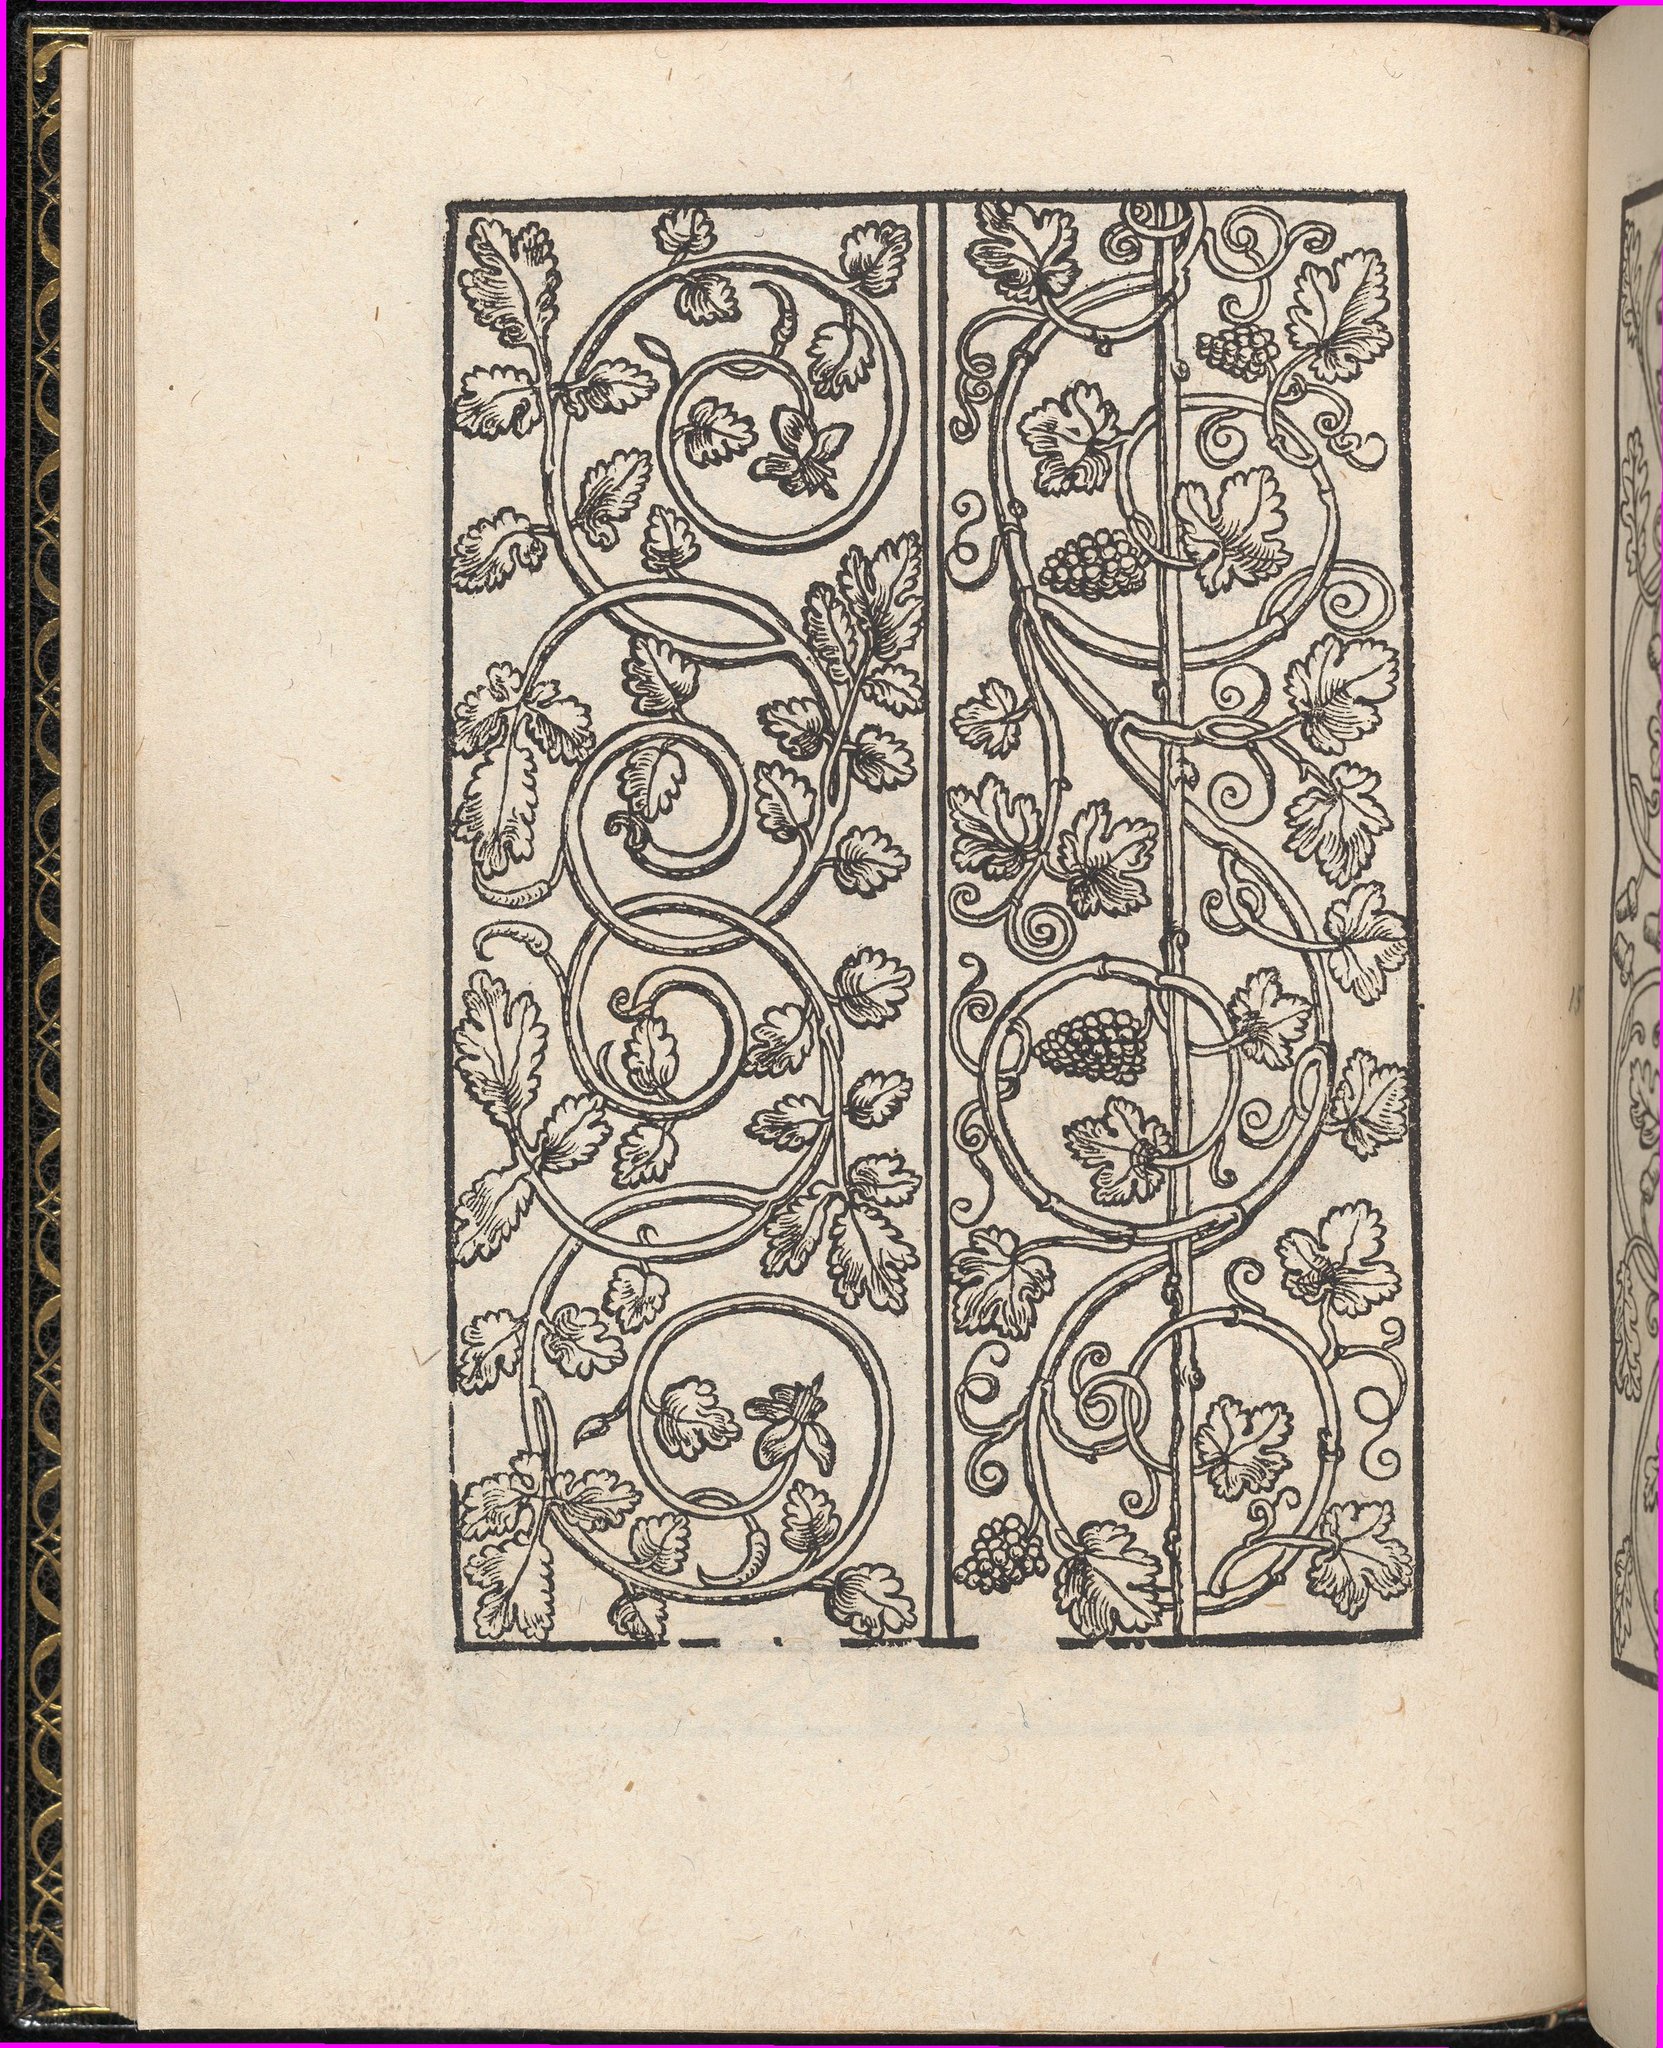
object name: book print ornament architecture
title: Page from Ein new kunstlich Modelbuch...(Page 15v)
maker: peter quentel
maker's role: publisher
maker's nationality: german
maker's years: 1500-1550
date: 1544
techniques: woodcut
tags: grapes,vines